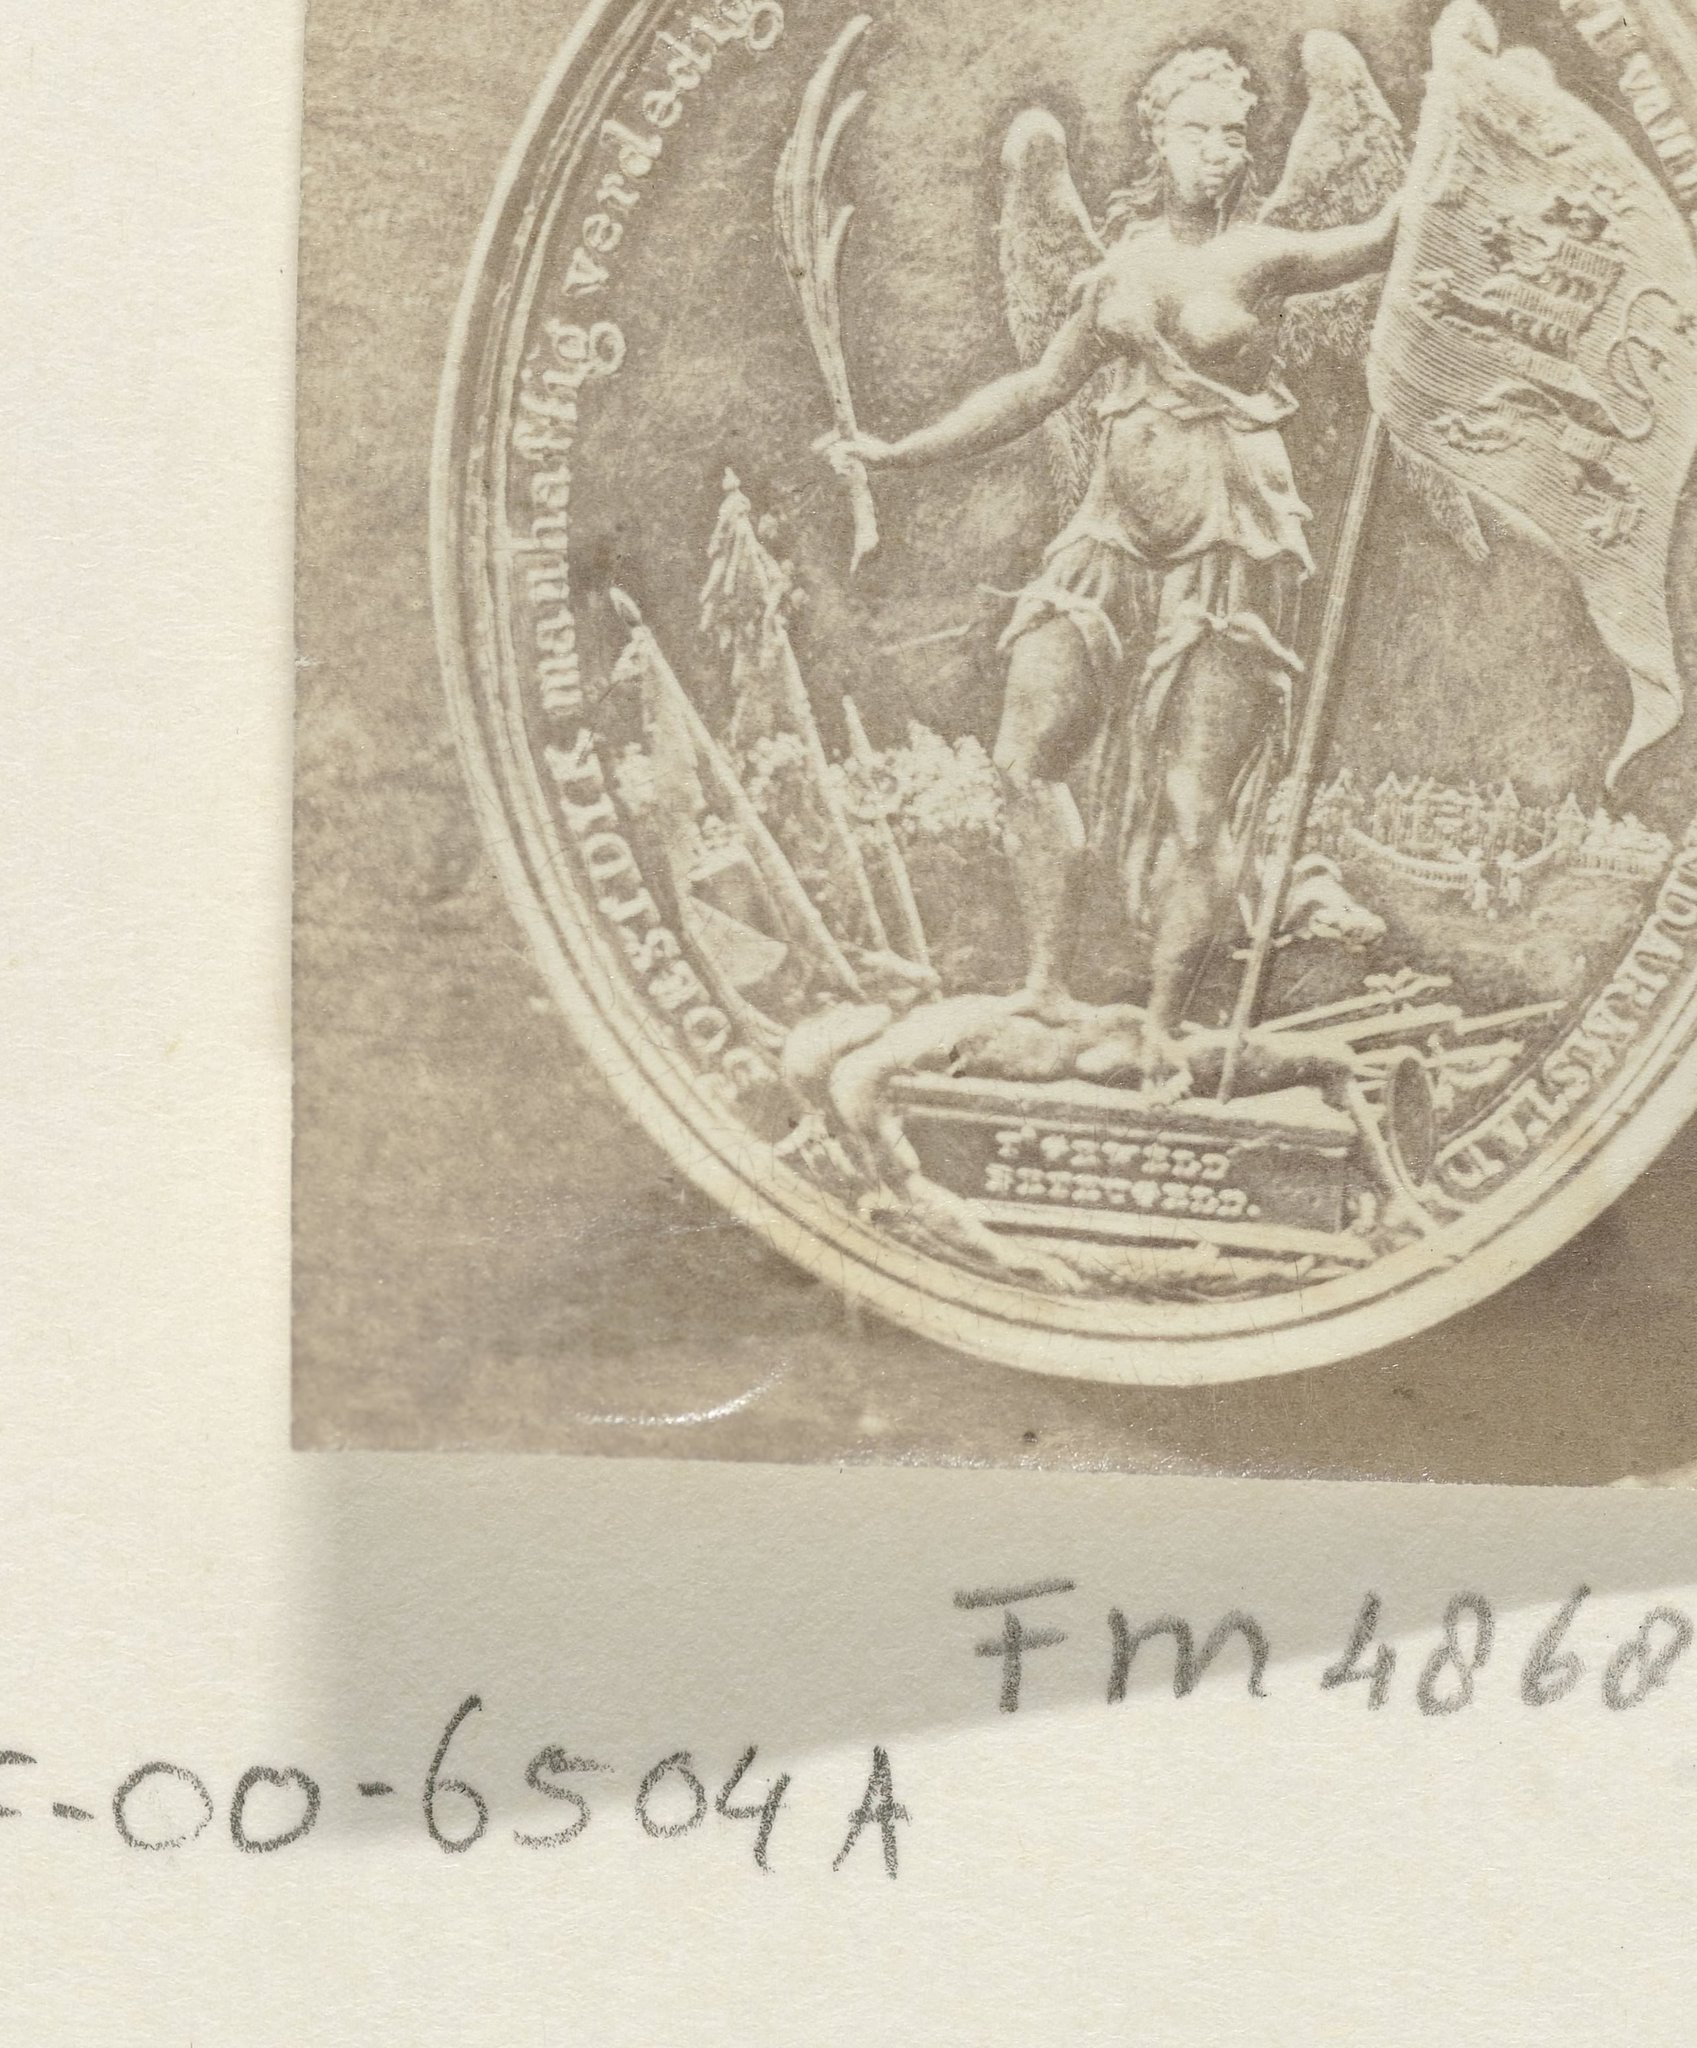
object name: photograph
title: Gedenkpenning voor de verdedigers van Soestdijk, 1787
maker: Anonymous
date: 1875-1876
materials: photographic support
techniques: collodion silver print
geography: netherlands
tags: medal (considered as a piece of sculpture, regardless of its specific function), patriots (1780-1795)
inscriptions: collector's mark: Lugt 2228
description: Voorzijde van de ovale gedenkpenning of draagteken uitgereikt aan de officieren van het regiment Hessen-Darmstadt dat Paleis te Soestdijk verdedigd heeft tegen de aanval van de patriotten uit Utrecht op 27 juli 1787.